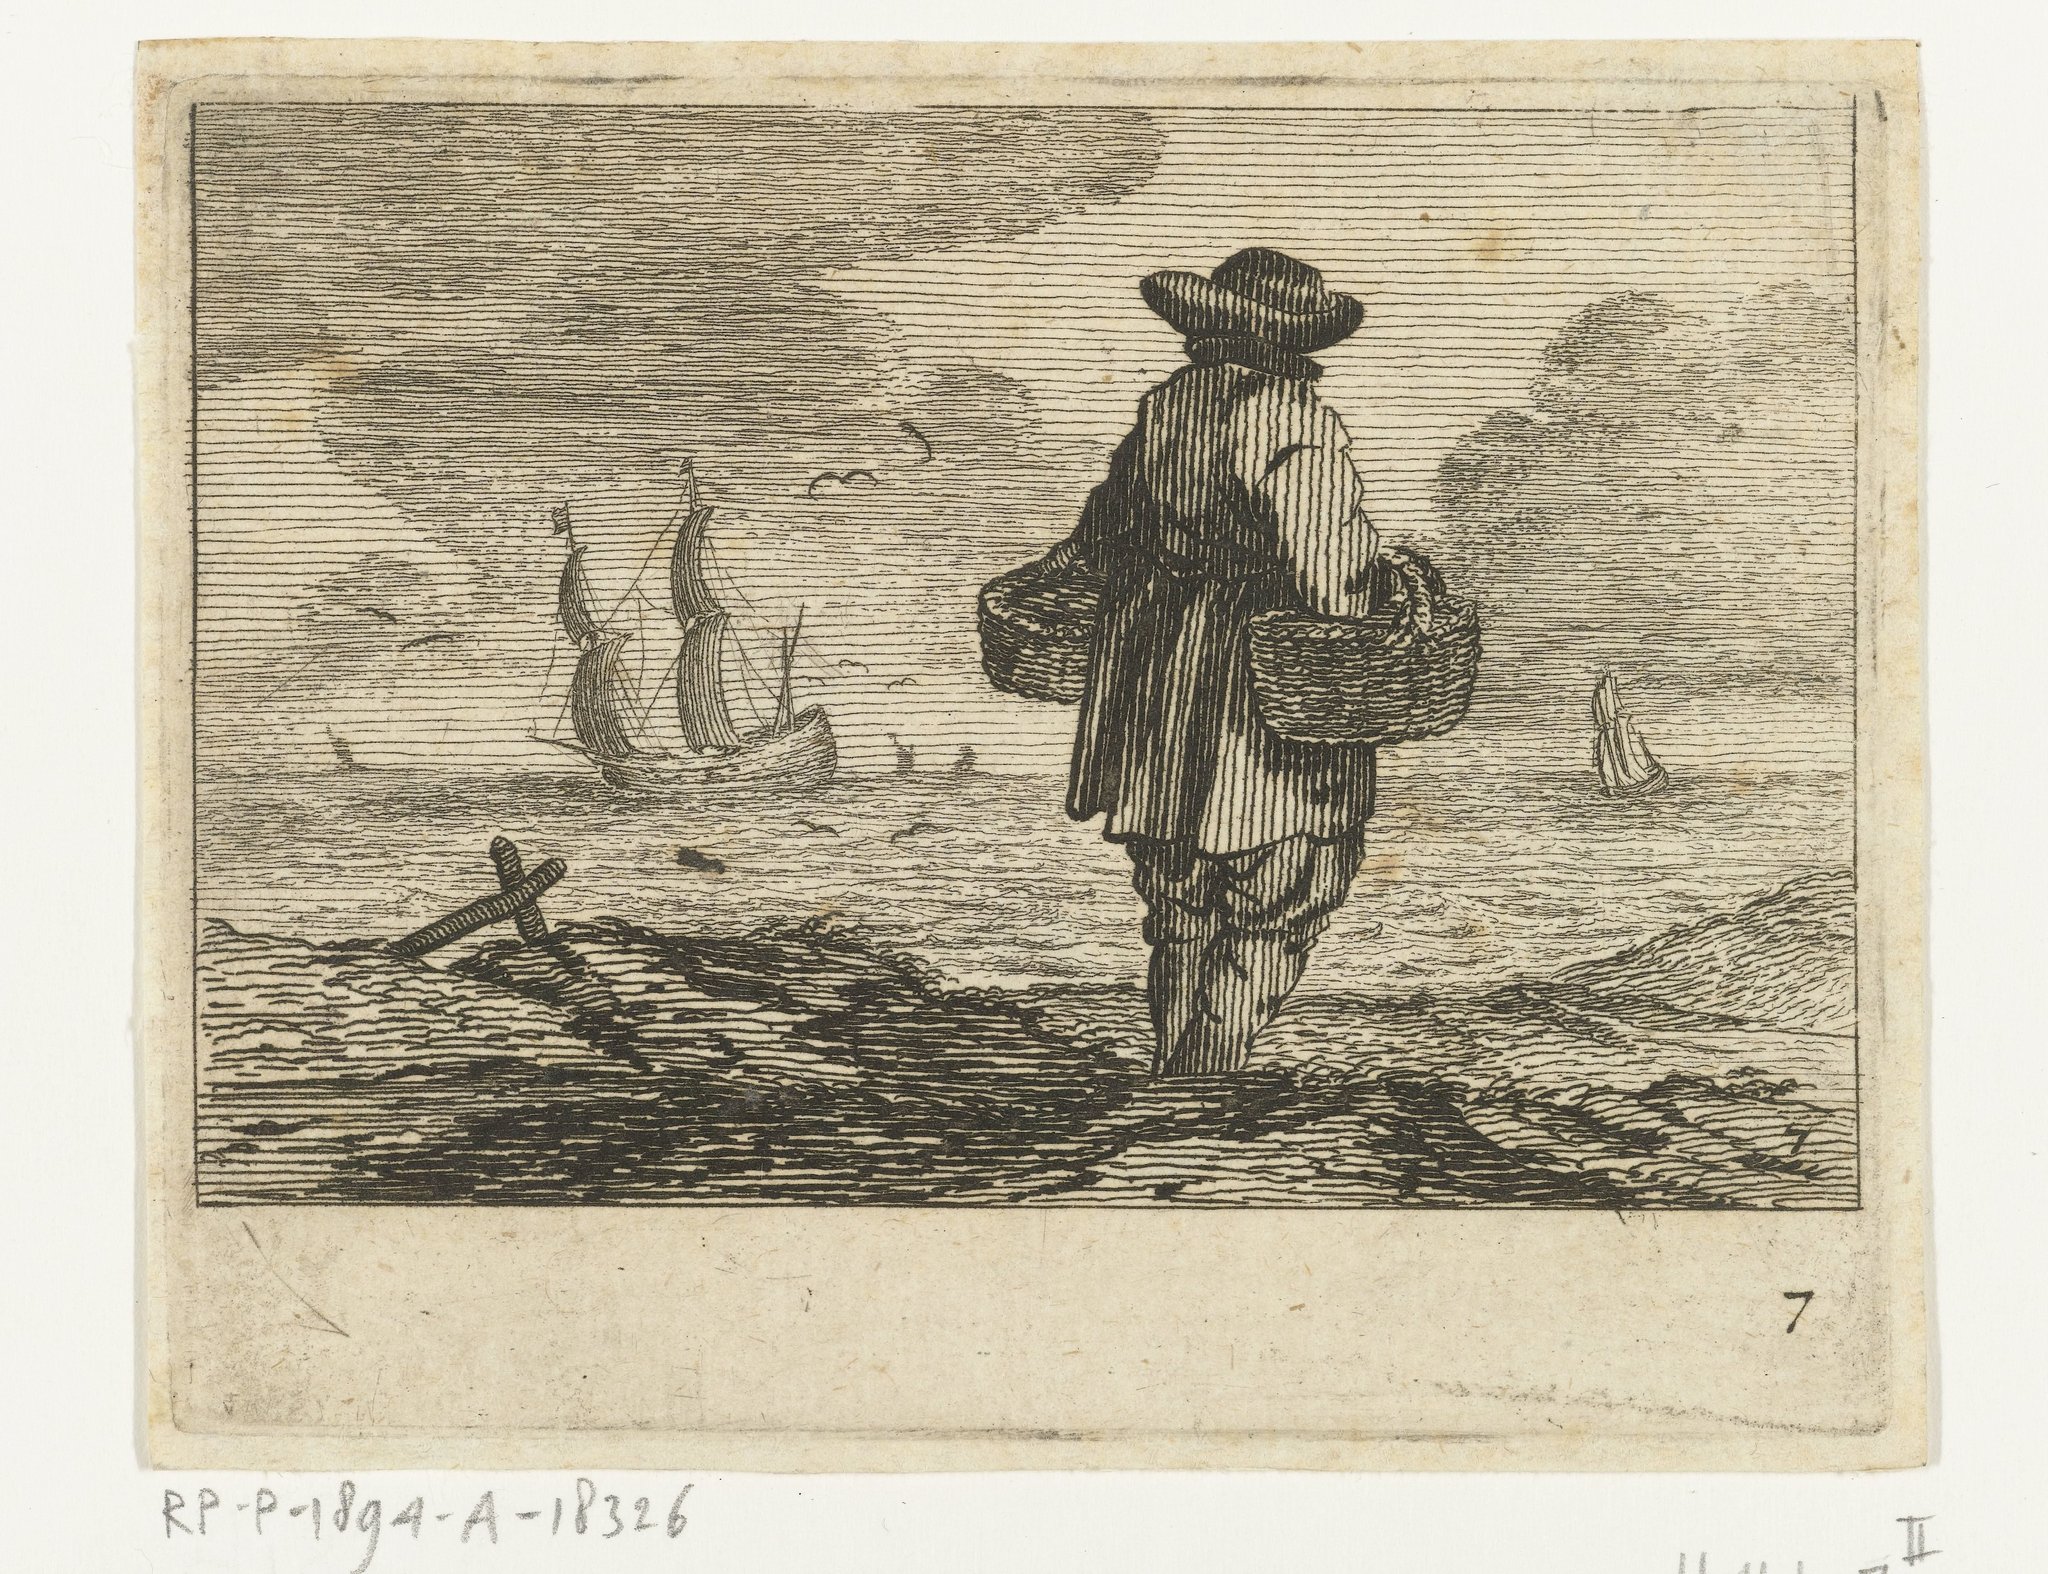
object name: print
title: Duinlandschap met een man, met twee manden aan de arm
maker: gillis van scheyndel (i)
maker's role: draughtsman, print maker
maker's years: 1595-1660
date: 1645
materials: paper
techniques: etching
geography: northern netherlands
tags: dune coast, carrying something in basket, bag, rucksack, etc.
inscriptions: collector's mark: Lugt 2228